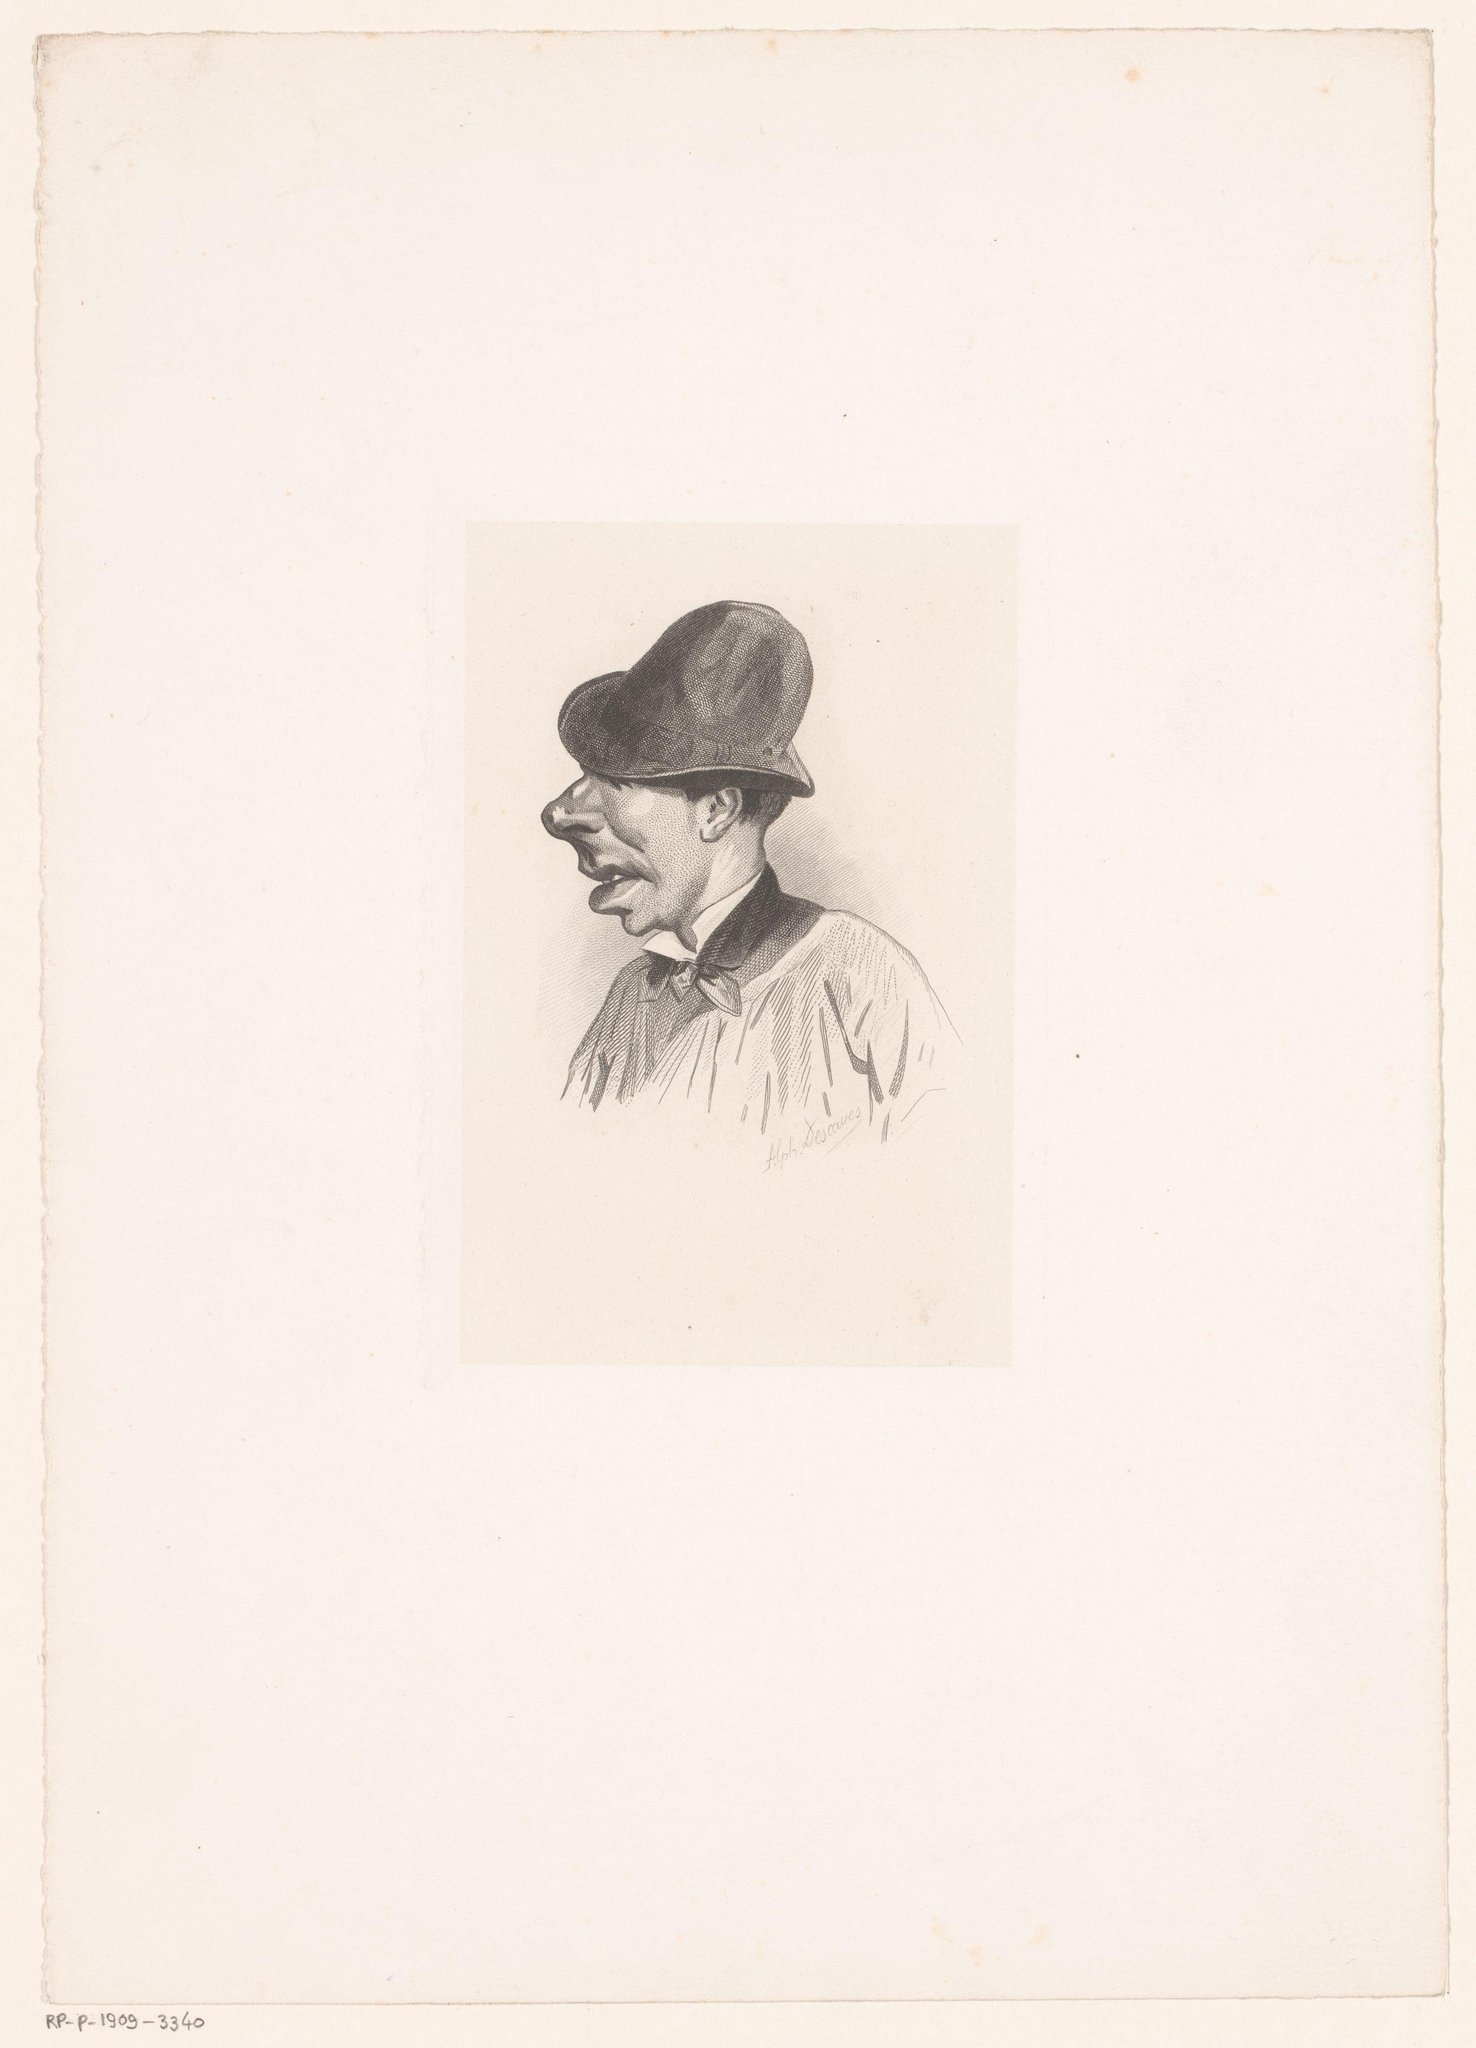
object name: print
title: Karikaturaal portret van Ernest Alexandre Honoré Coquelin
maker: alphonse descaves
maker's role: print maker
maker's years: 1830-1890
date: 1840-1890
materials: paper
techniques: engraving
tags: caricatures (human types), historical persons, portrait of actor, actress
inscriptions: collector's mark: Lugt 2228